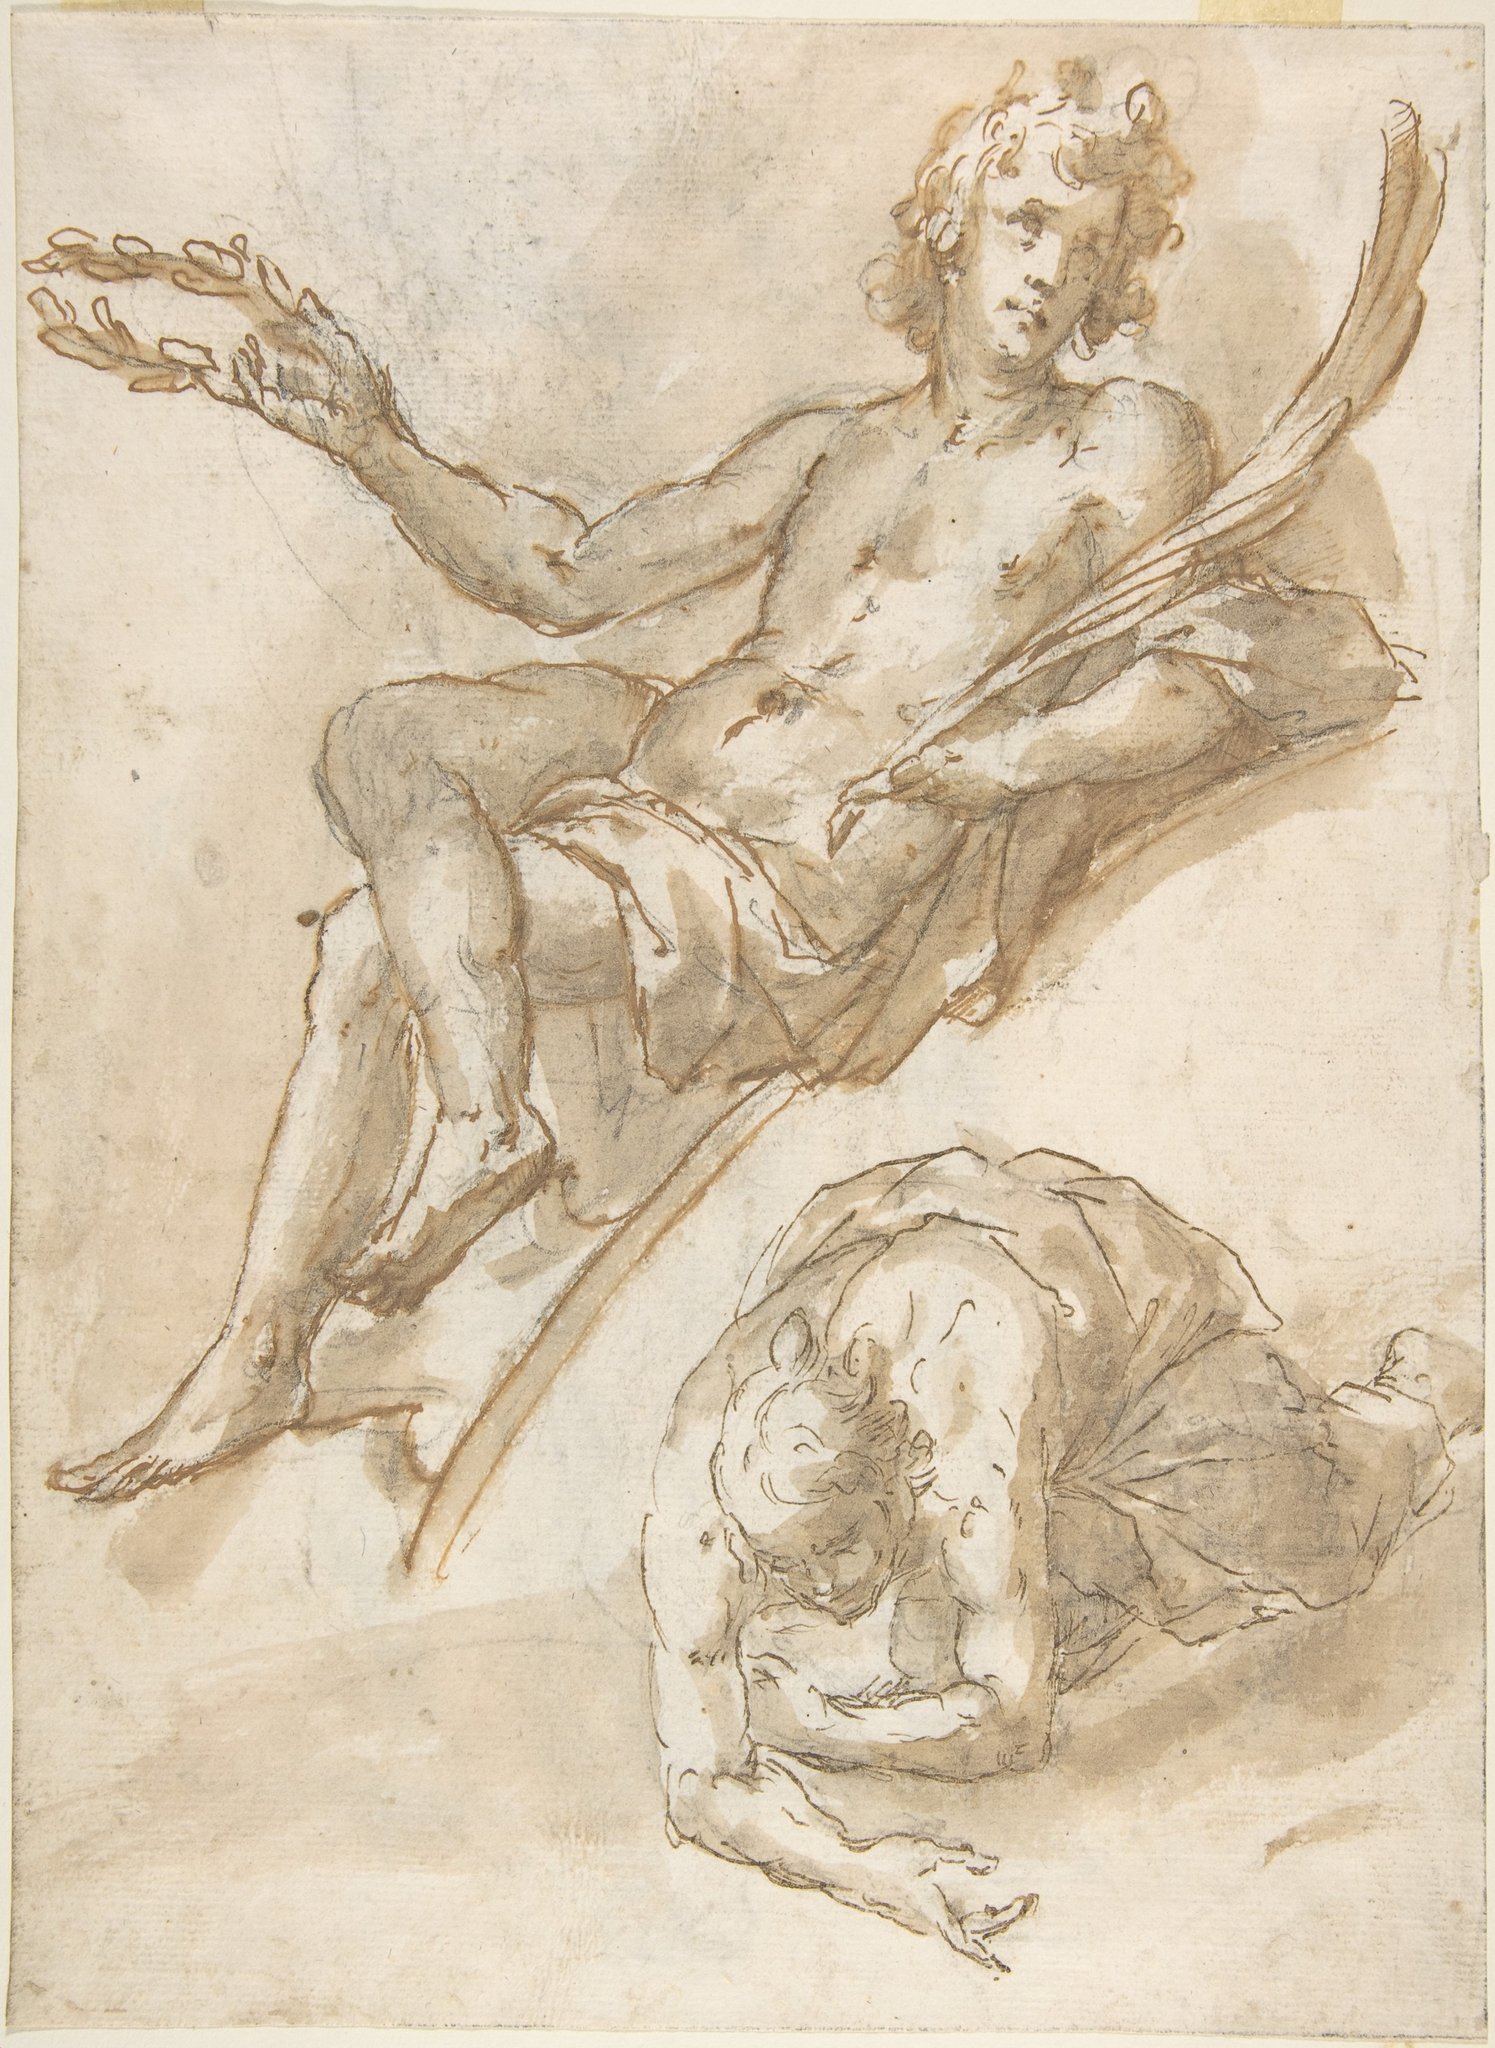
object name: drawing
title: Two Figures (recto); Standing Figure (Young Hercules?) (verso)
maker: anonymous, spanish, school of seville, 17th century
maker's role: artist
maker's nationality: spanish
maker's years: 1600-1700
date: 1601-1700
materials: chalk, ink, paper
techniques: brush, pen, drawing, wash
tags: men,hercules